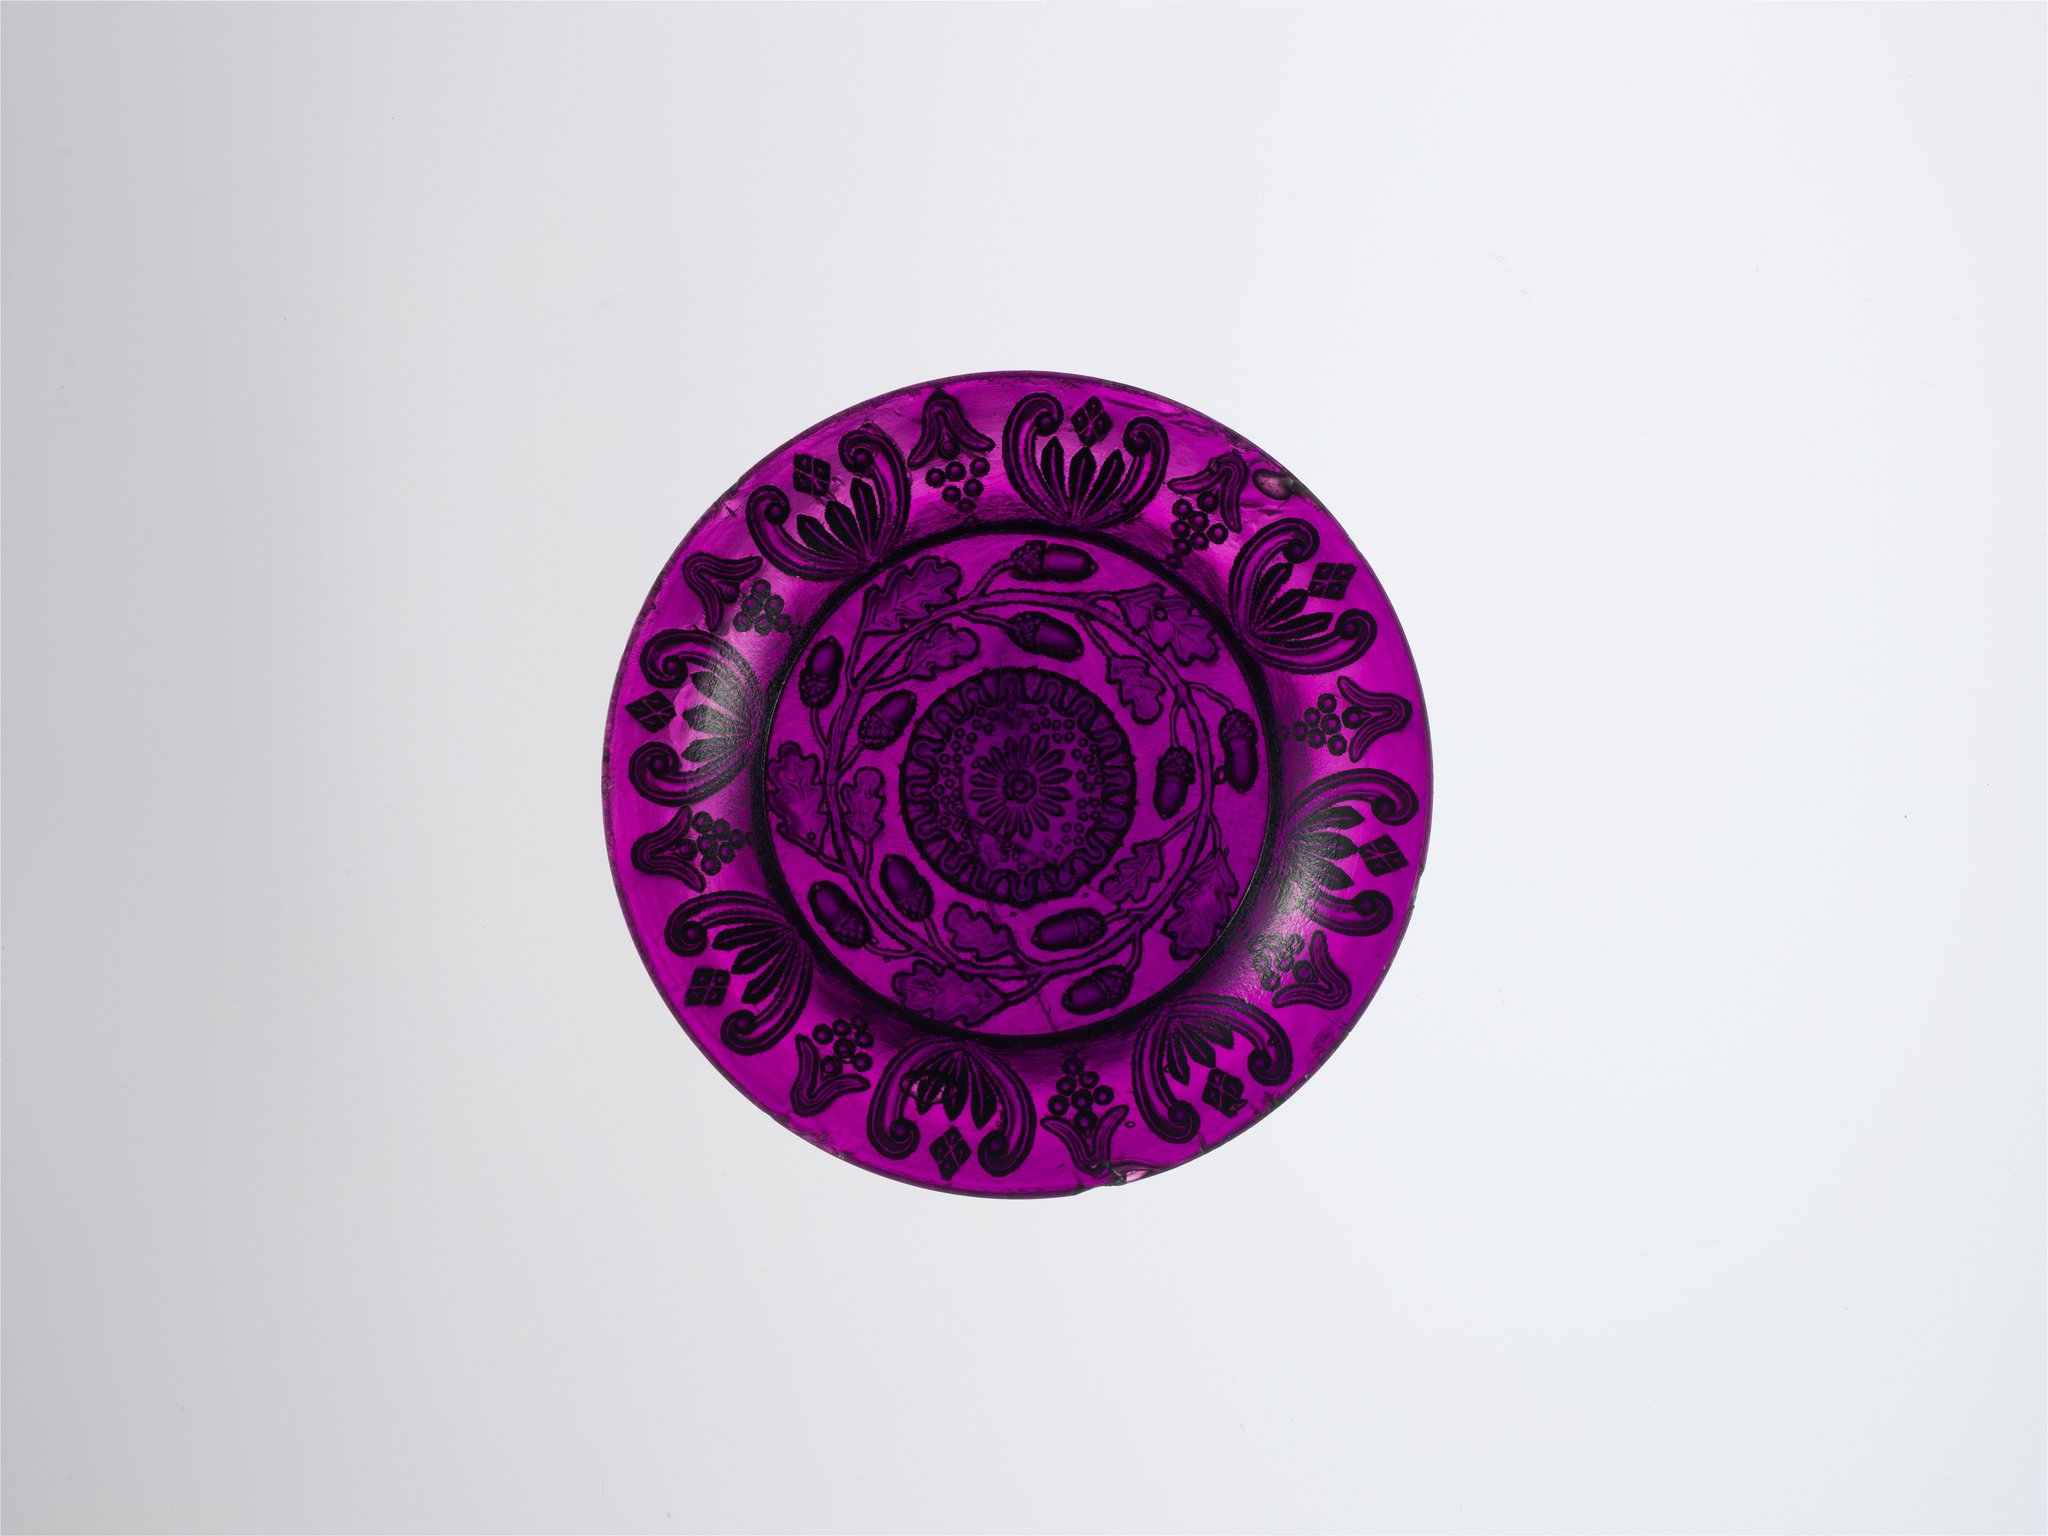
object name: cup plate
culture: american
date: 1825-1860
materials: glass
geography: united states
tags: flowers